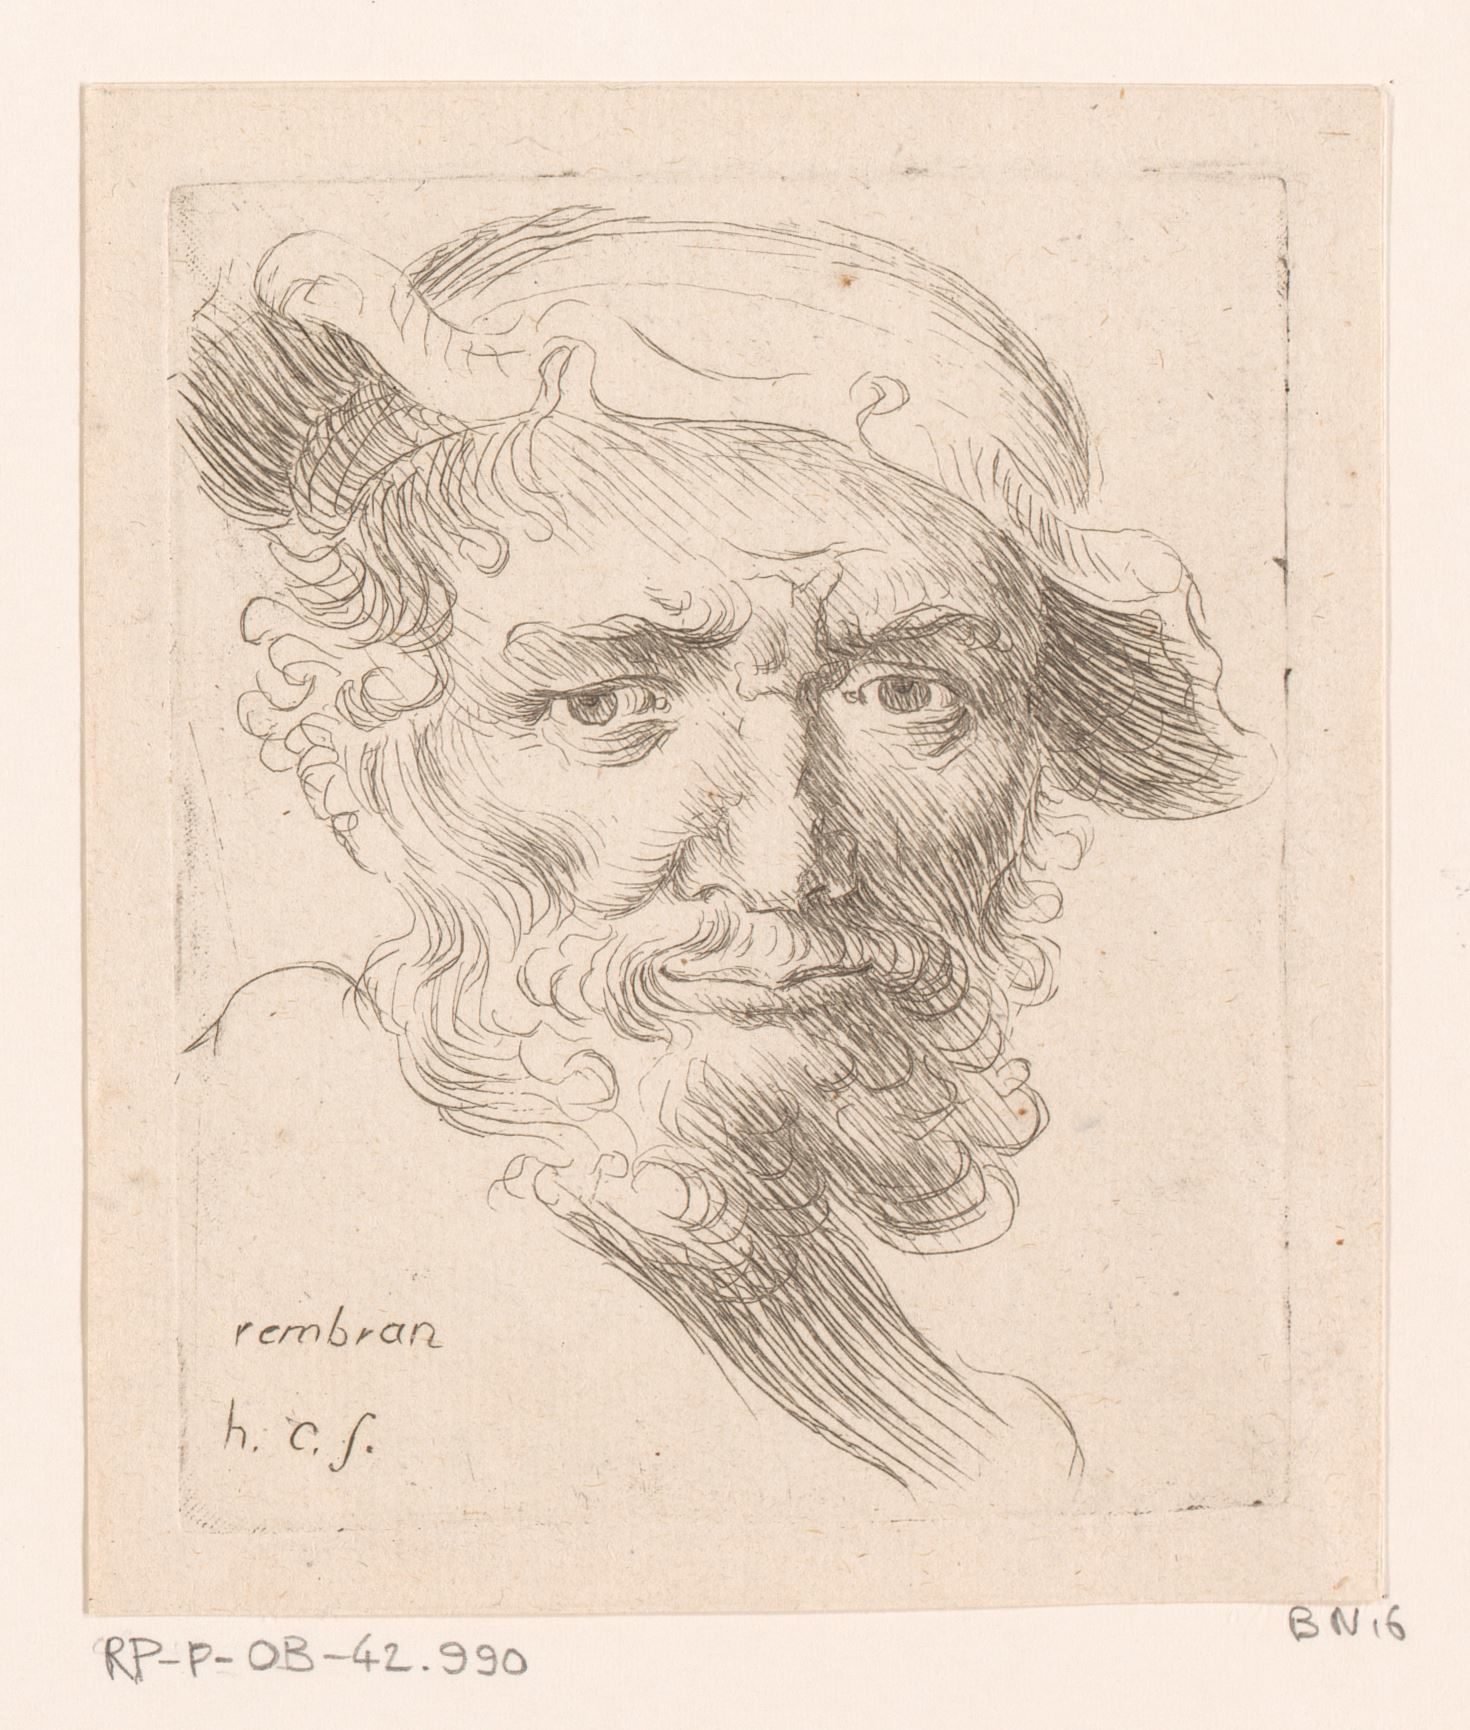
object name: print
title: Buste van een oude man met baard en muts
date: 1708-1779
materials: paper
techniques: etching, roulette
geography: france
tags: head-gear: cap (+ men's clothes), old man, beard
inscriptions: collector's mark: Lugt 240